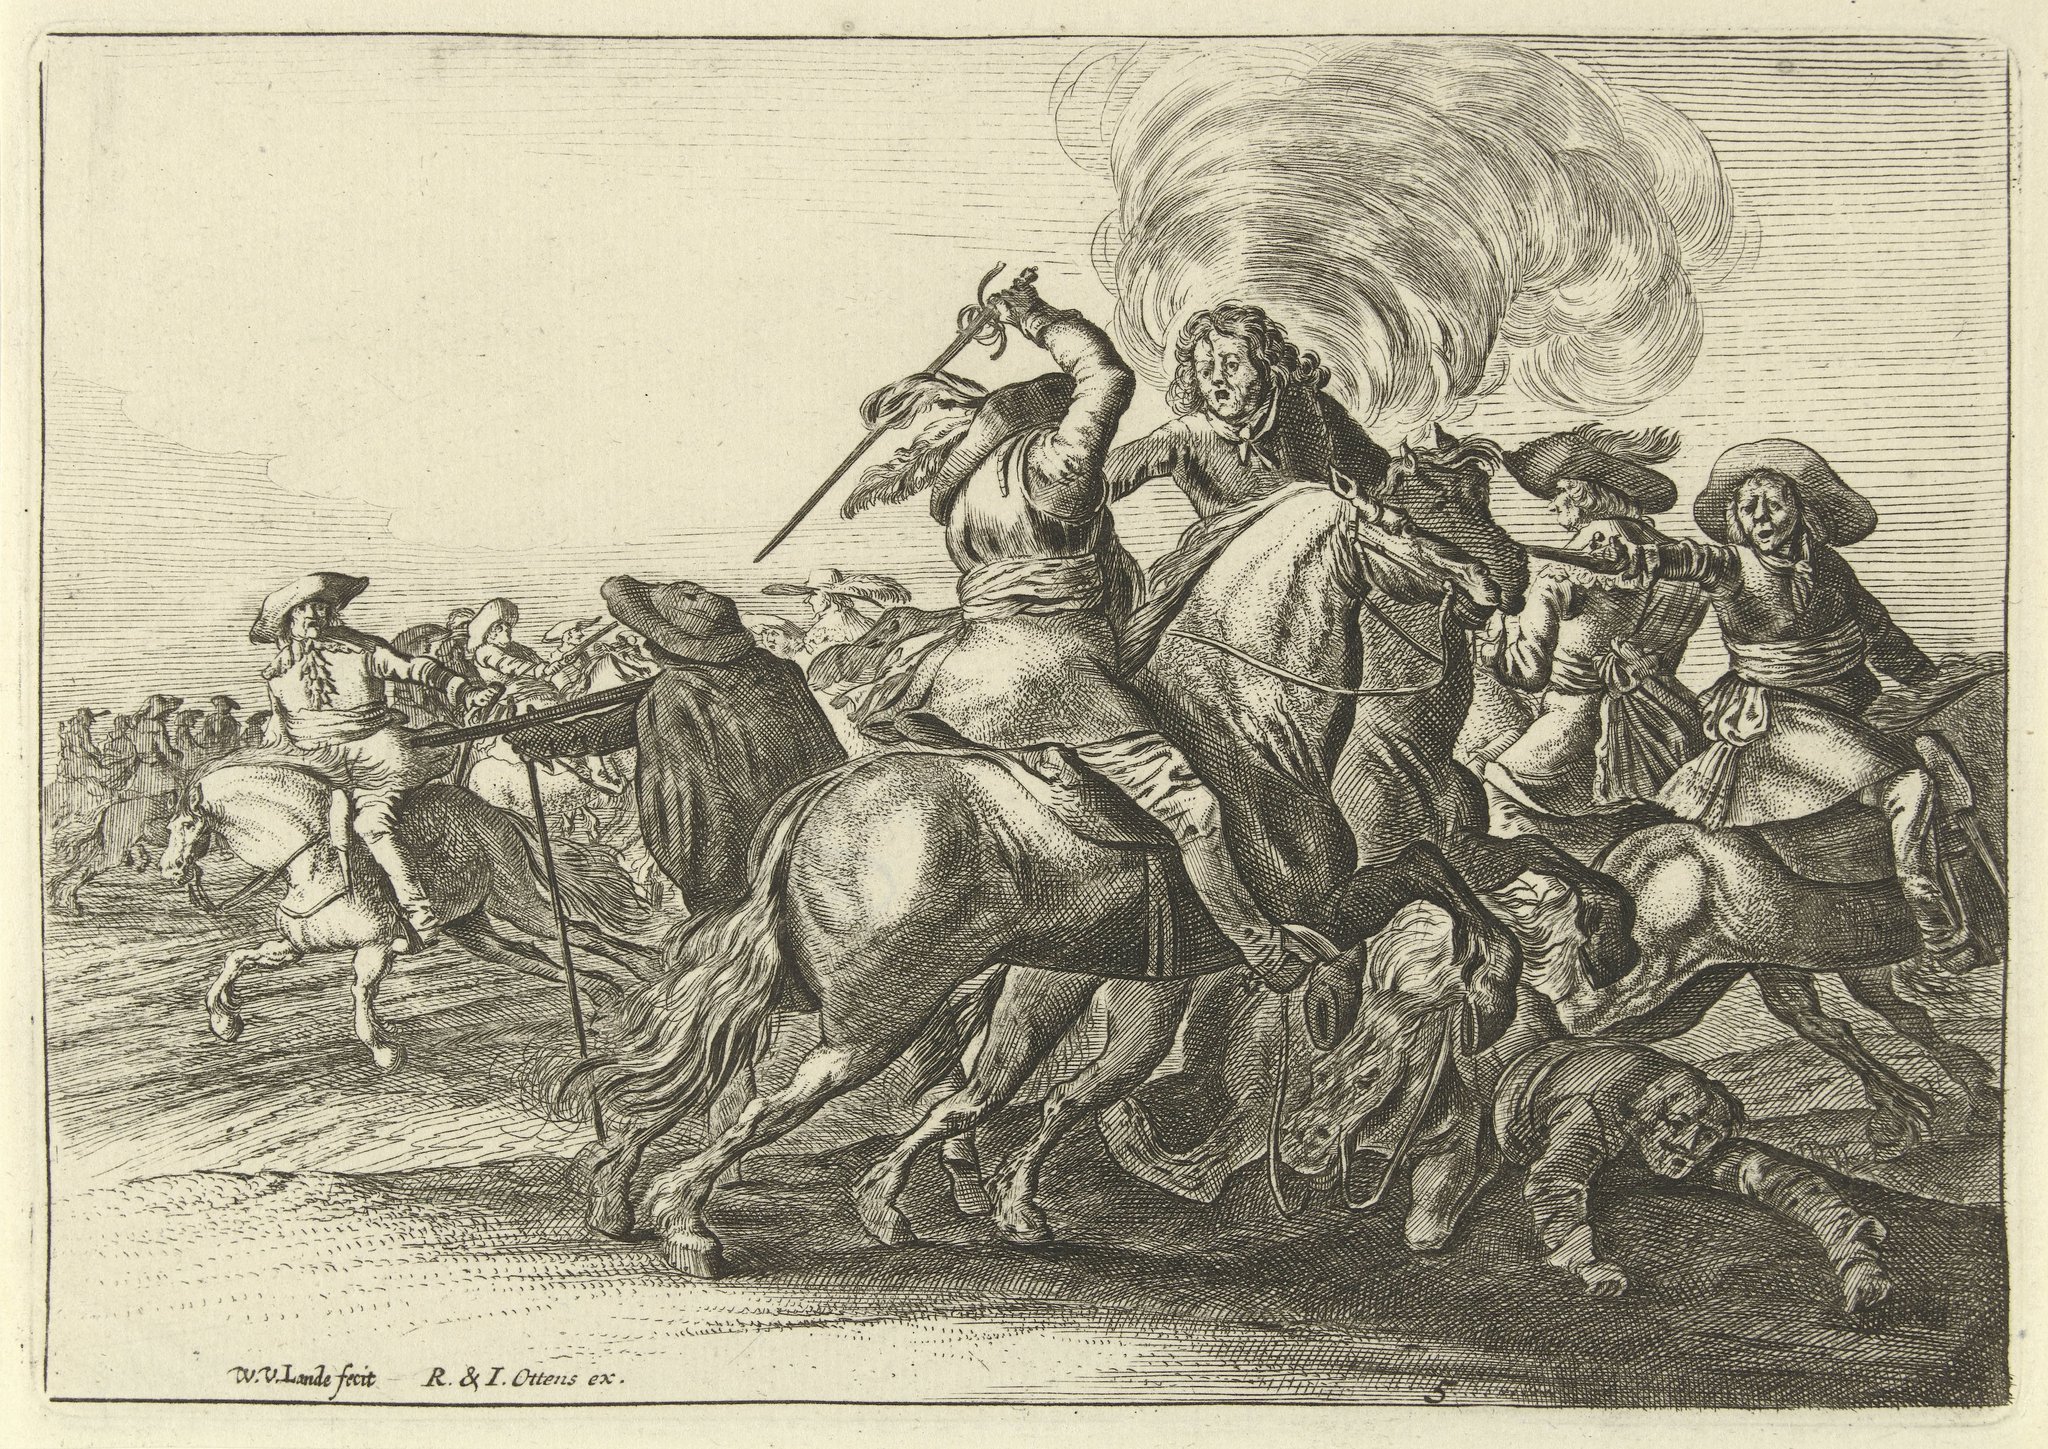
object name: print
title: Slagveldscène met vechtende ruiters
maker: willem van de lande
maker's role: print maker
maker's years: 1610-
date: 1635-1650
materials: paper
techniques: etching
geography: amsterdam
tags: riding a horse, ass, or mule; rider, horseman, battle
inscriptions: collector's mark: Lugt 2228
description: Slagveldscène met ruiters die elkaar met zwaarden, speren en pistolen te lijf gaan. Op de voorgrond haalt een ruiter met een zwaard uit naar zijn tegenstander, hun paarden vertrappen een op de grond gelegen ruiter en zijn paard. De prent maakt deel uit van een zesdelige serie prenten met ruitergevechten. Prent rechts van het midden genummerd: 5.